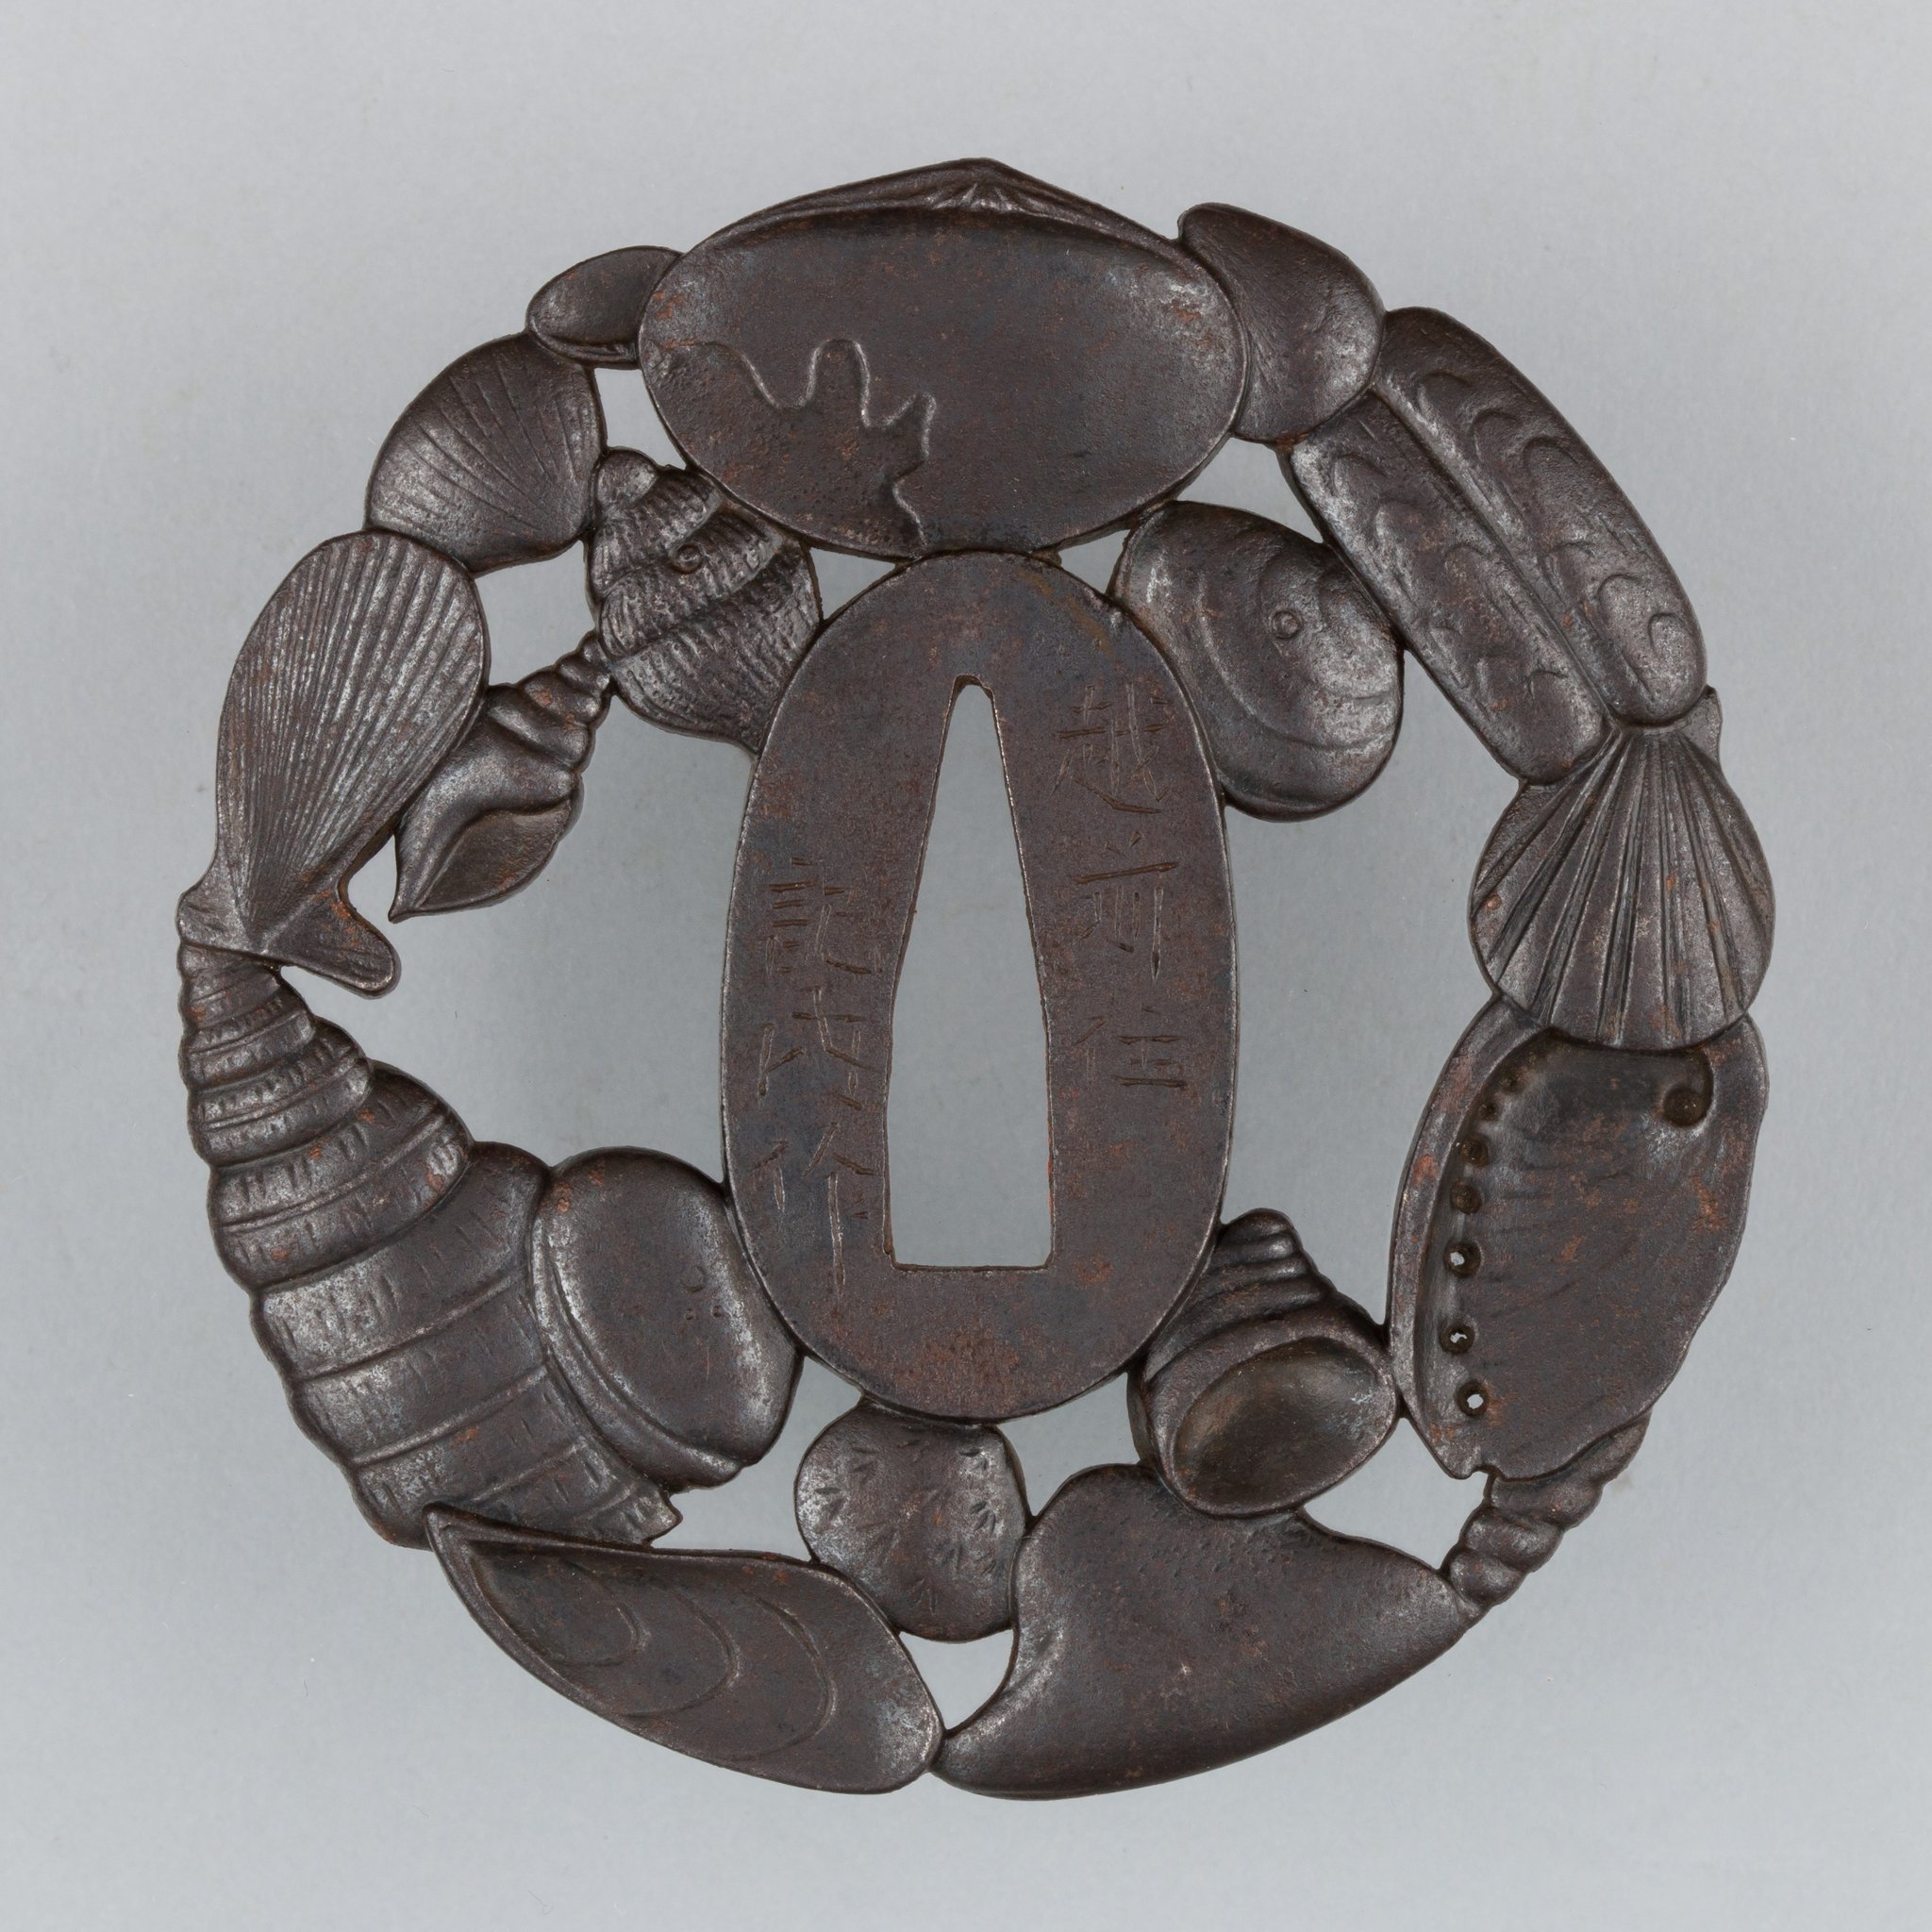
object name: sword guard tsuba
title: Sword Guard (Tsuba)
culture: japanese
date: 1601-1700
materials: copper, iron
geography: japan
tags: shells